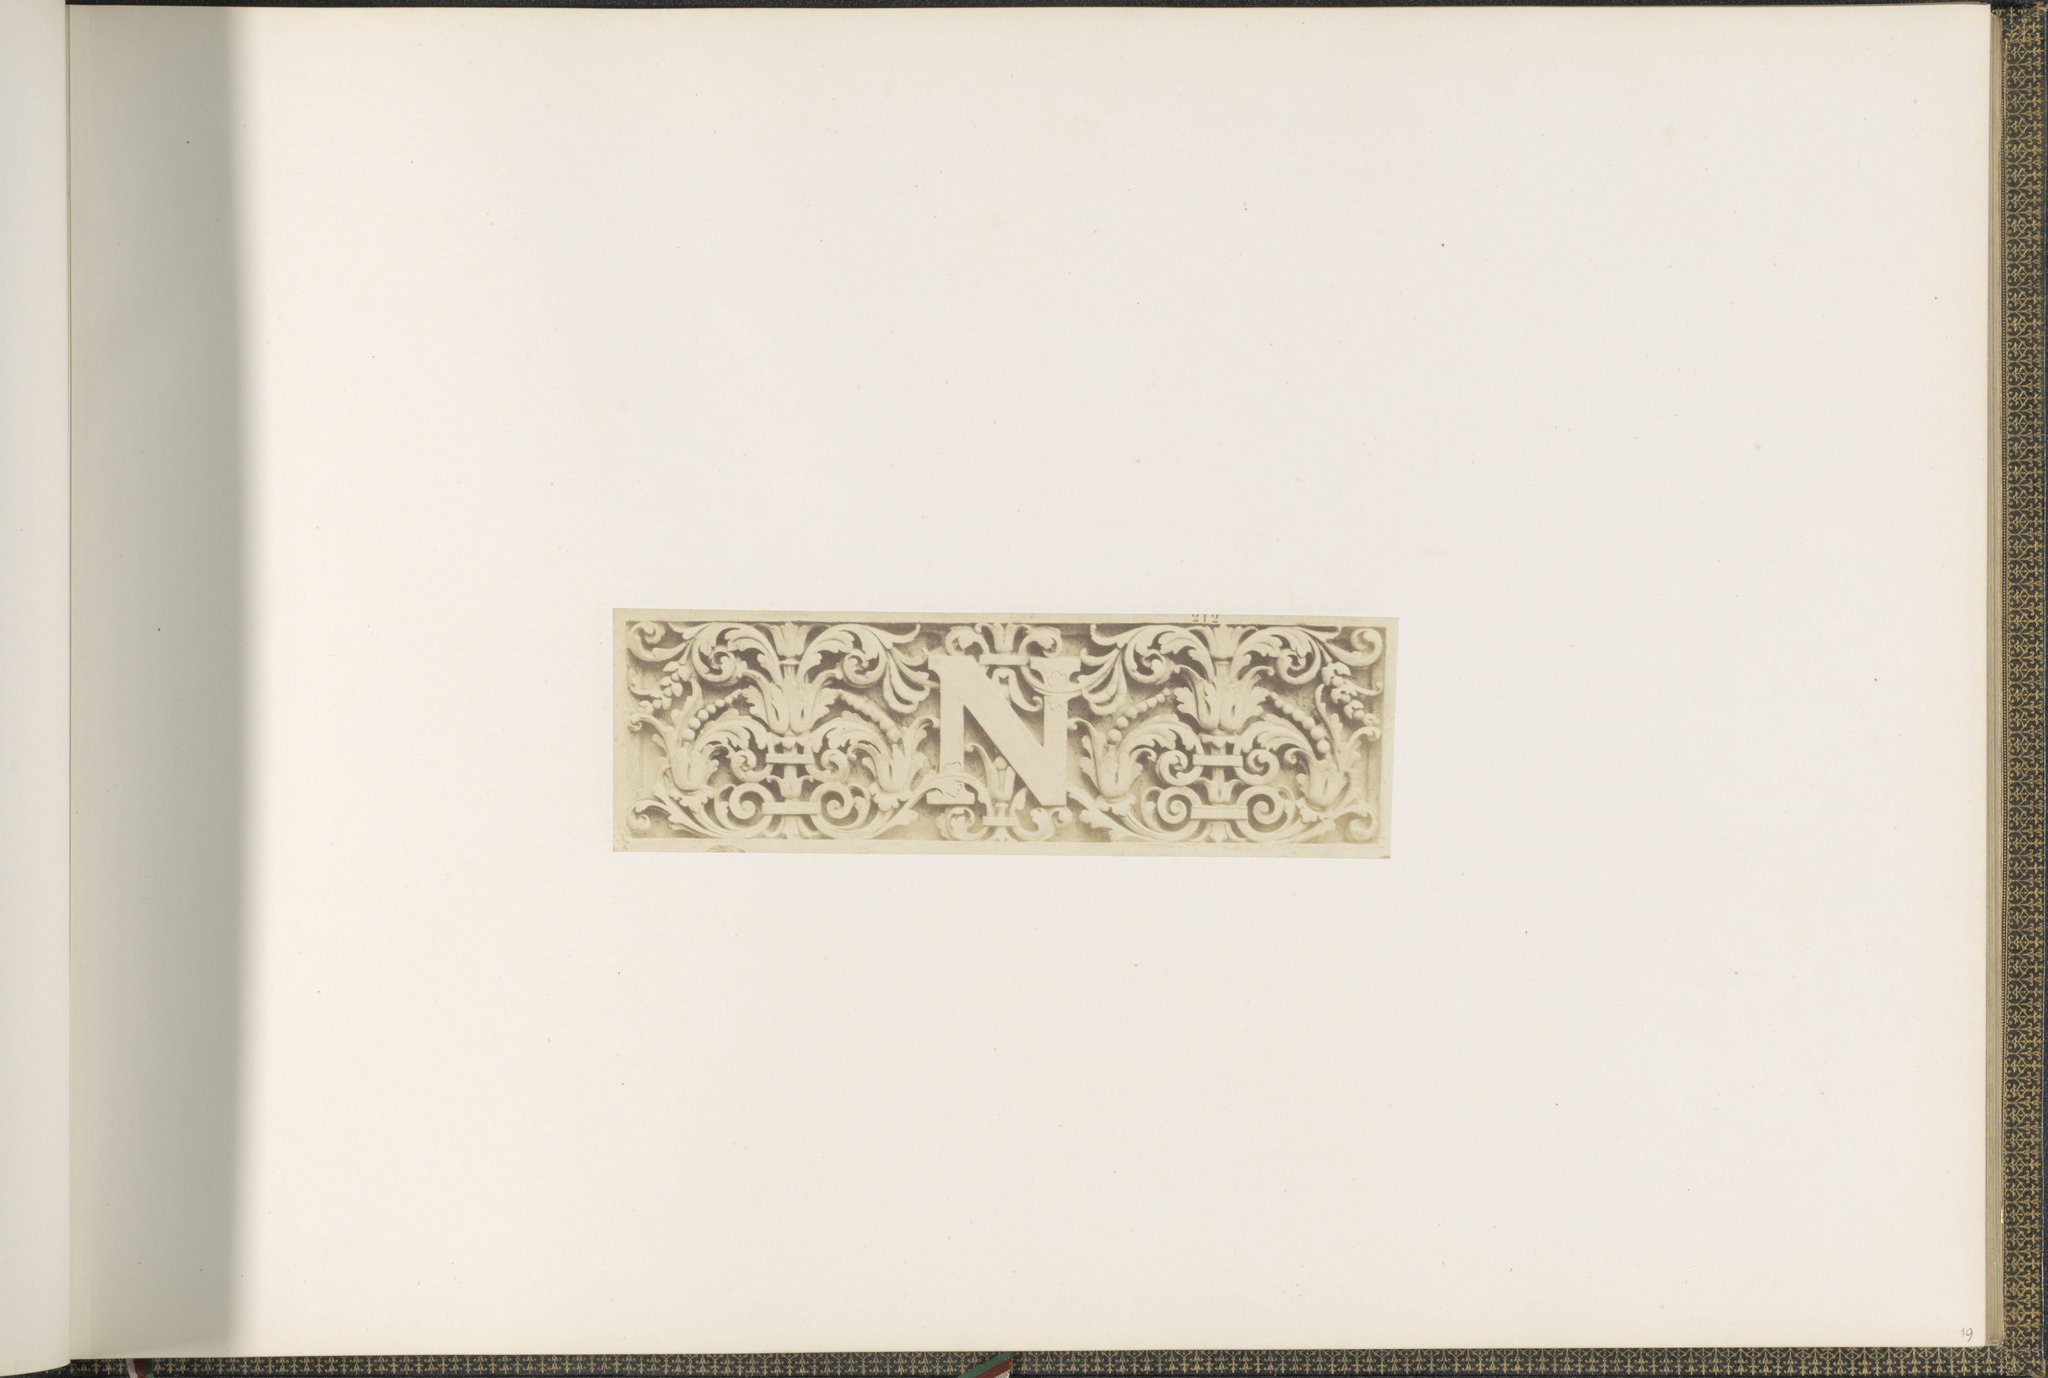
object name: photograph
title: Gipsmodel voor een friesversiering op het Palais du Louvre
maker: édouard denis baldus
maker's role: fotograaf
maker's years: 1813-1889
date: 1855-1857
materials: paper, photographic support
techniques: salted paper print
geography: paris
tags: permanent exhibition, museum, ornamenting, decorating ~ applied arts, paris, tuileries palace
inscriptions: number: ‘212’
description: Onderdeel van Réunion des Tuileries au Louvre 1852-1857, album 4.